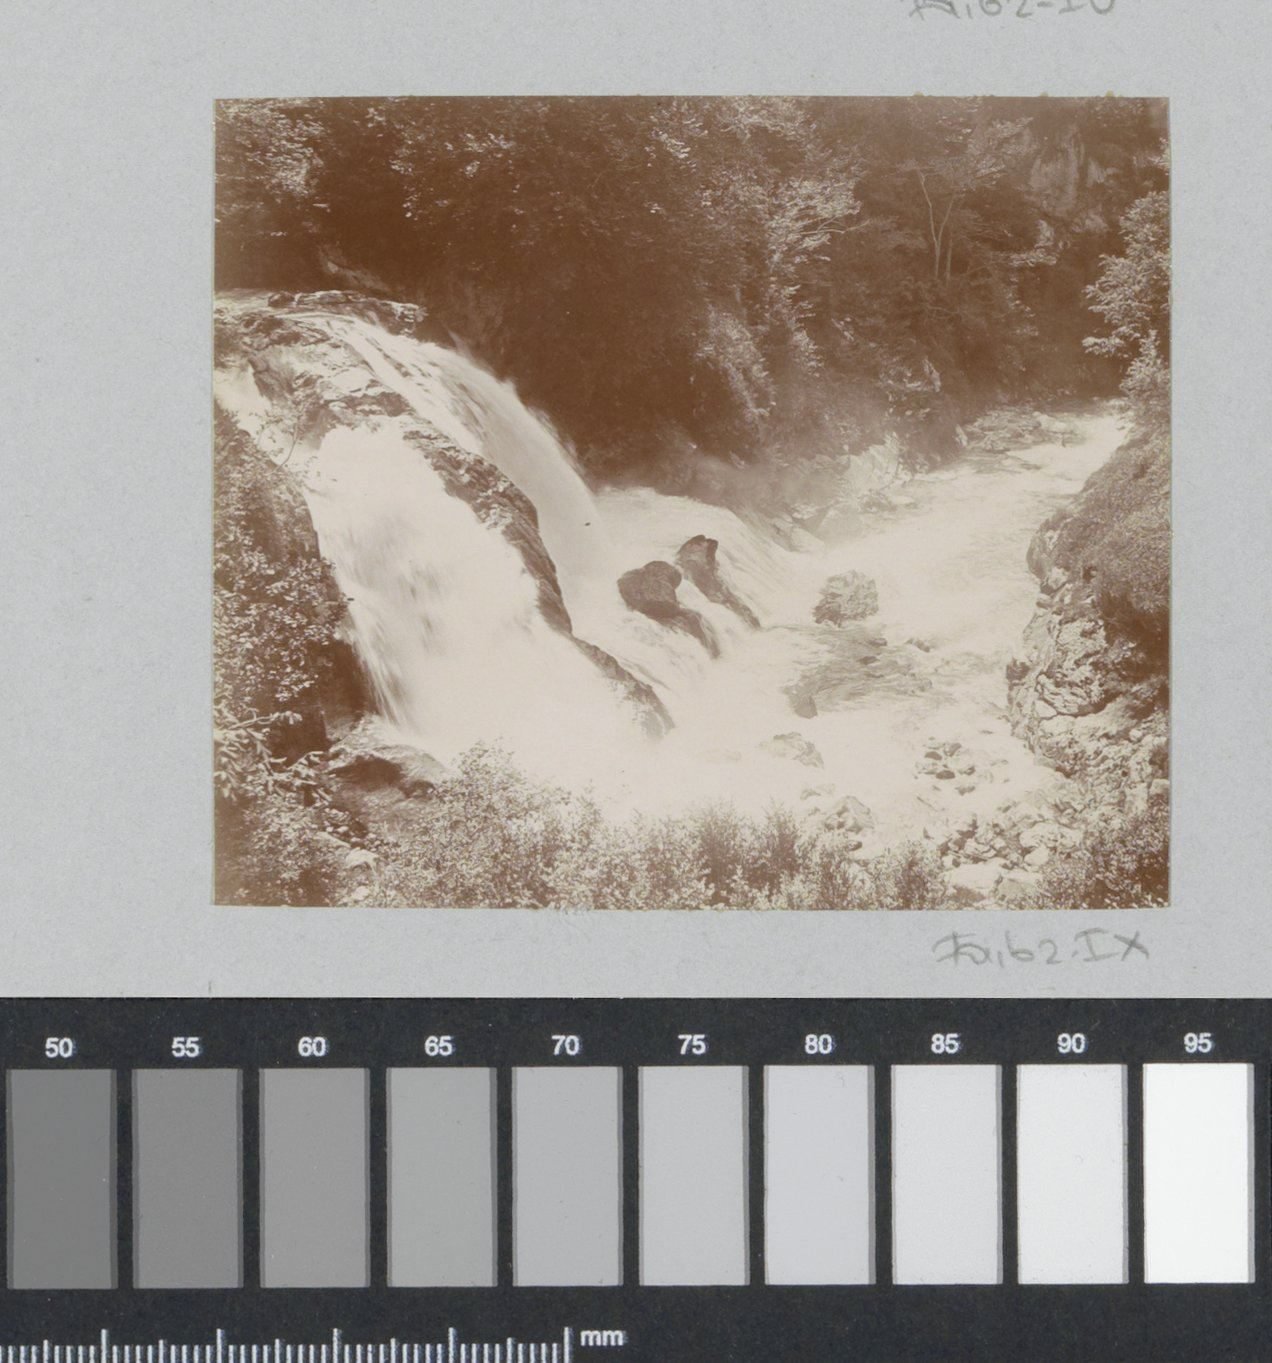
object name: photograph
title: Waterval in een beek, vermoedelijk in Frankrijk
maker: Anonymous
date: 1905-1910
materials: paper, photographic support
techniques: gelatin silver print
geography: france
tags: waterfall, brook, france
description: Onderdeel van Fotoalbum van een Franse amateurfotograaf met bezienswaardigheden in Frankrijk, Zwitserland en Italië.